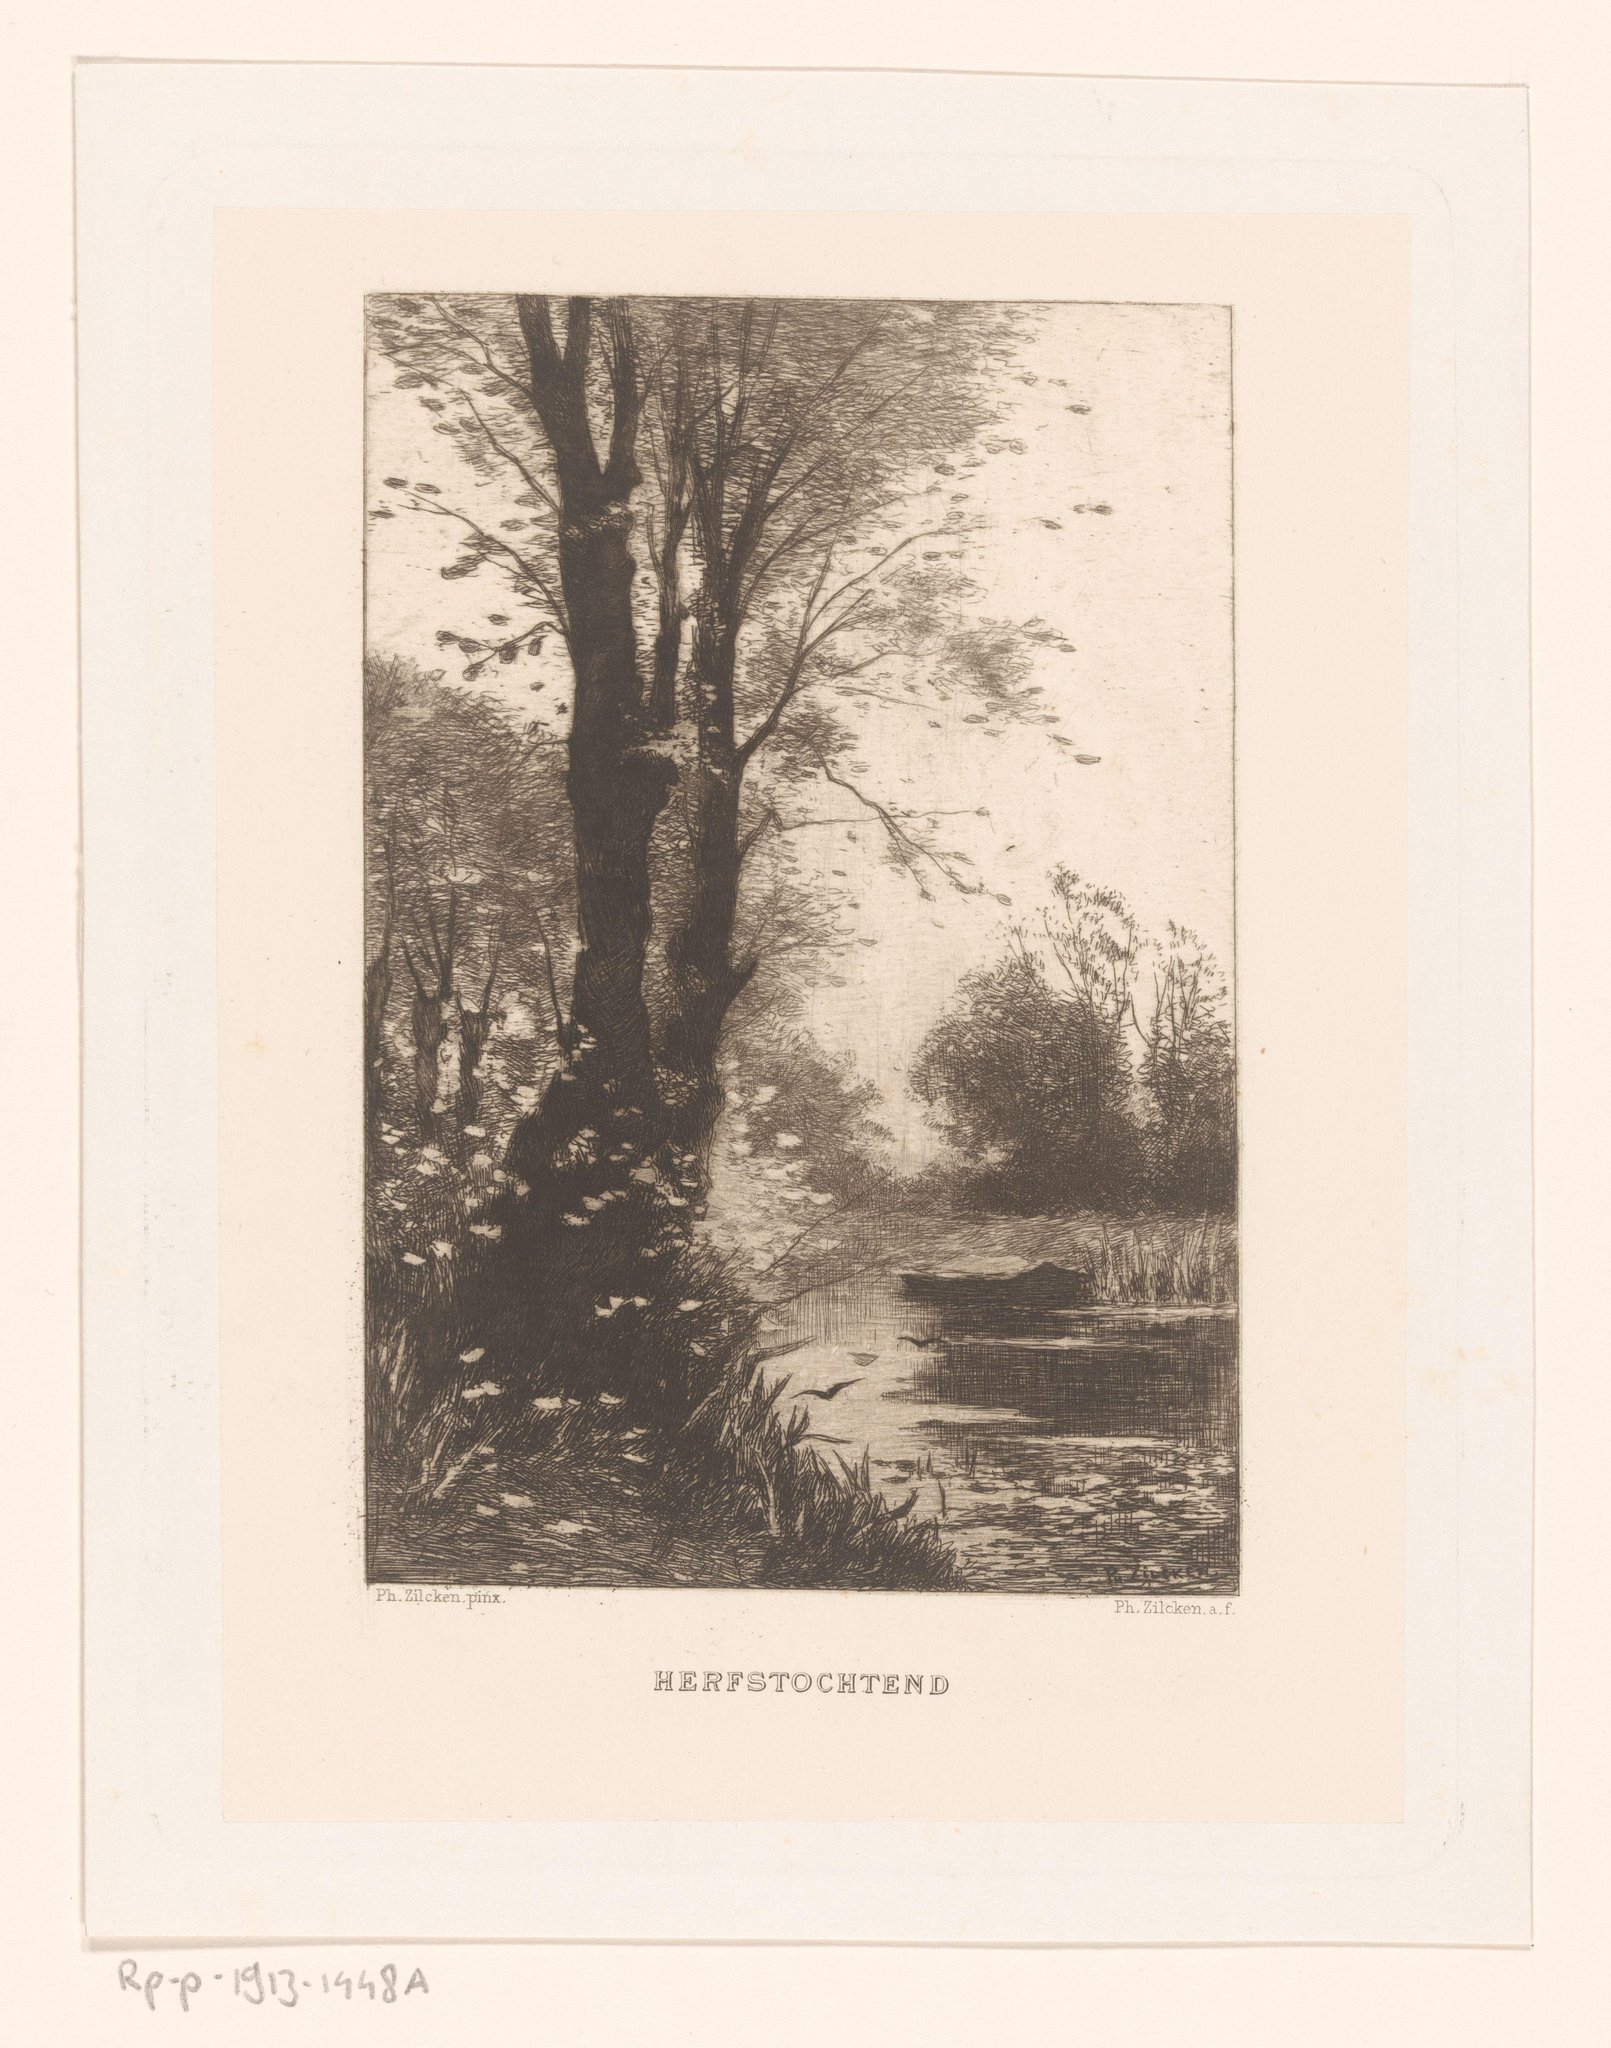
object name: print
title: Herfstochtend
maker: philip zilcken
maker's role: draughtsman, painter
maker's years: 1857-1930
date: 1867-1890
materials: paper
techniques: drypoint, etching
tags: trees, pond, pool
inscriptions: collector's mark: Lugt 2228